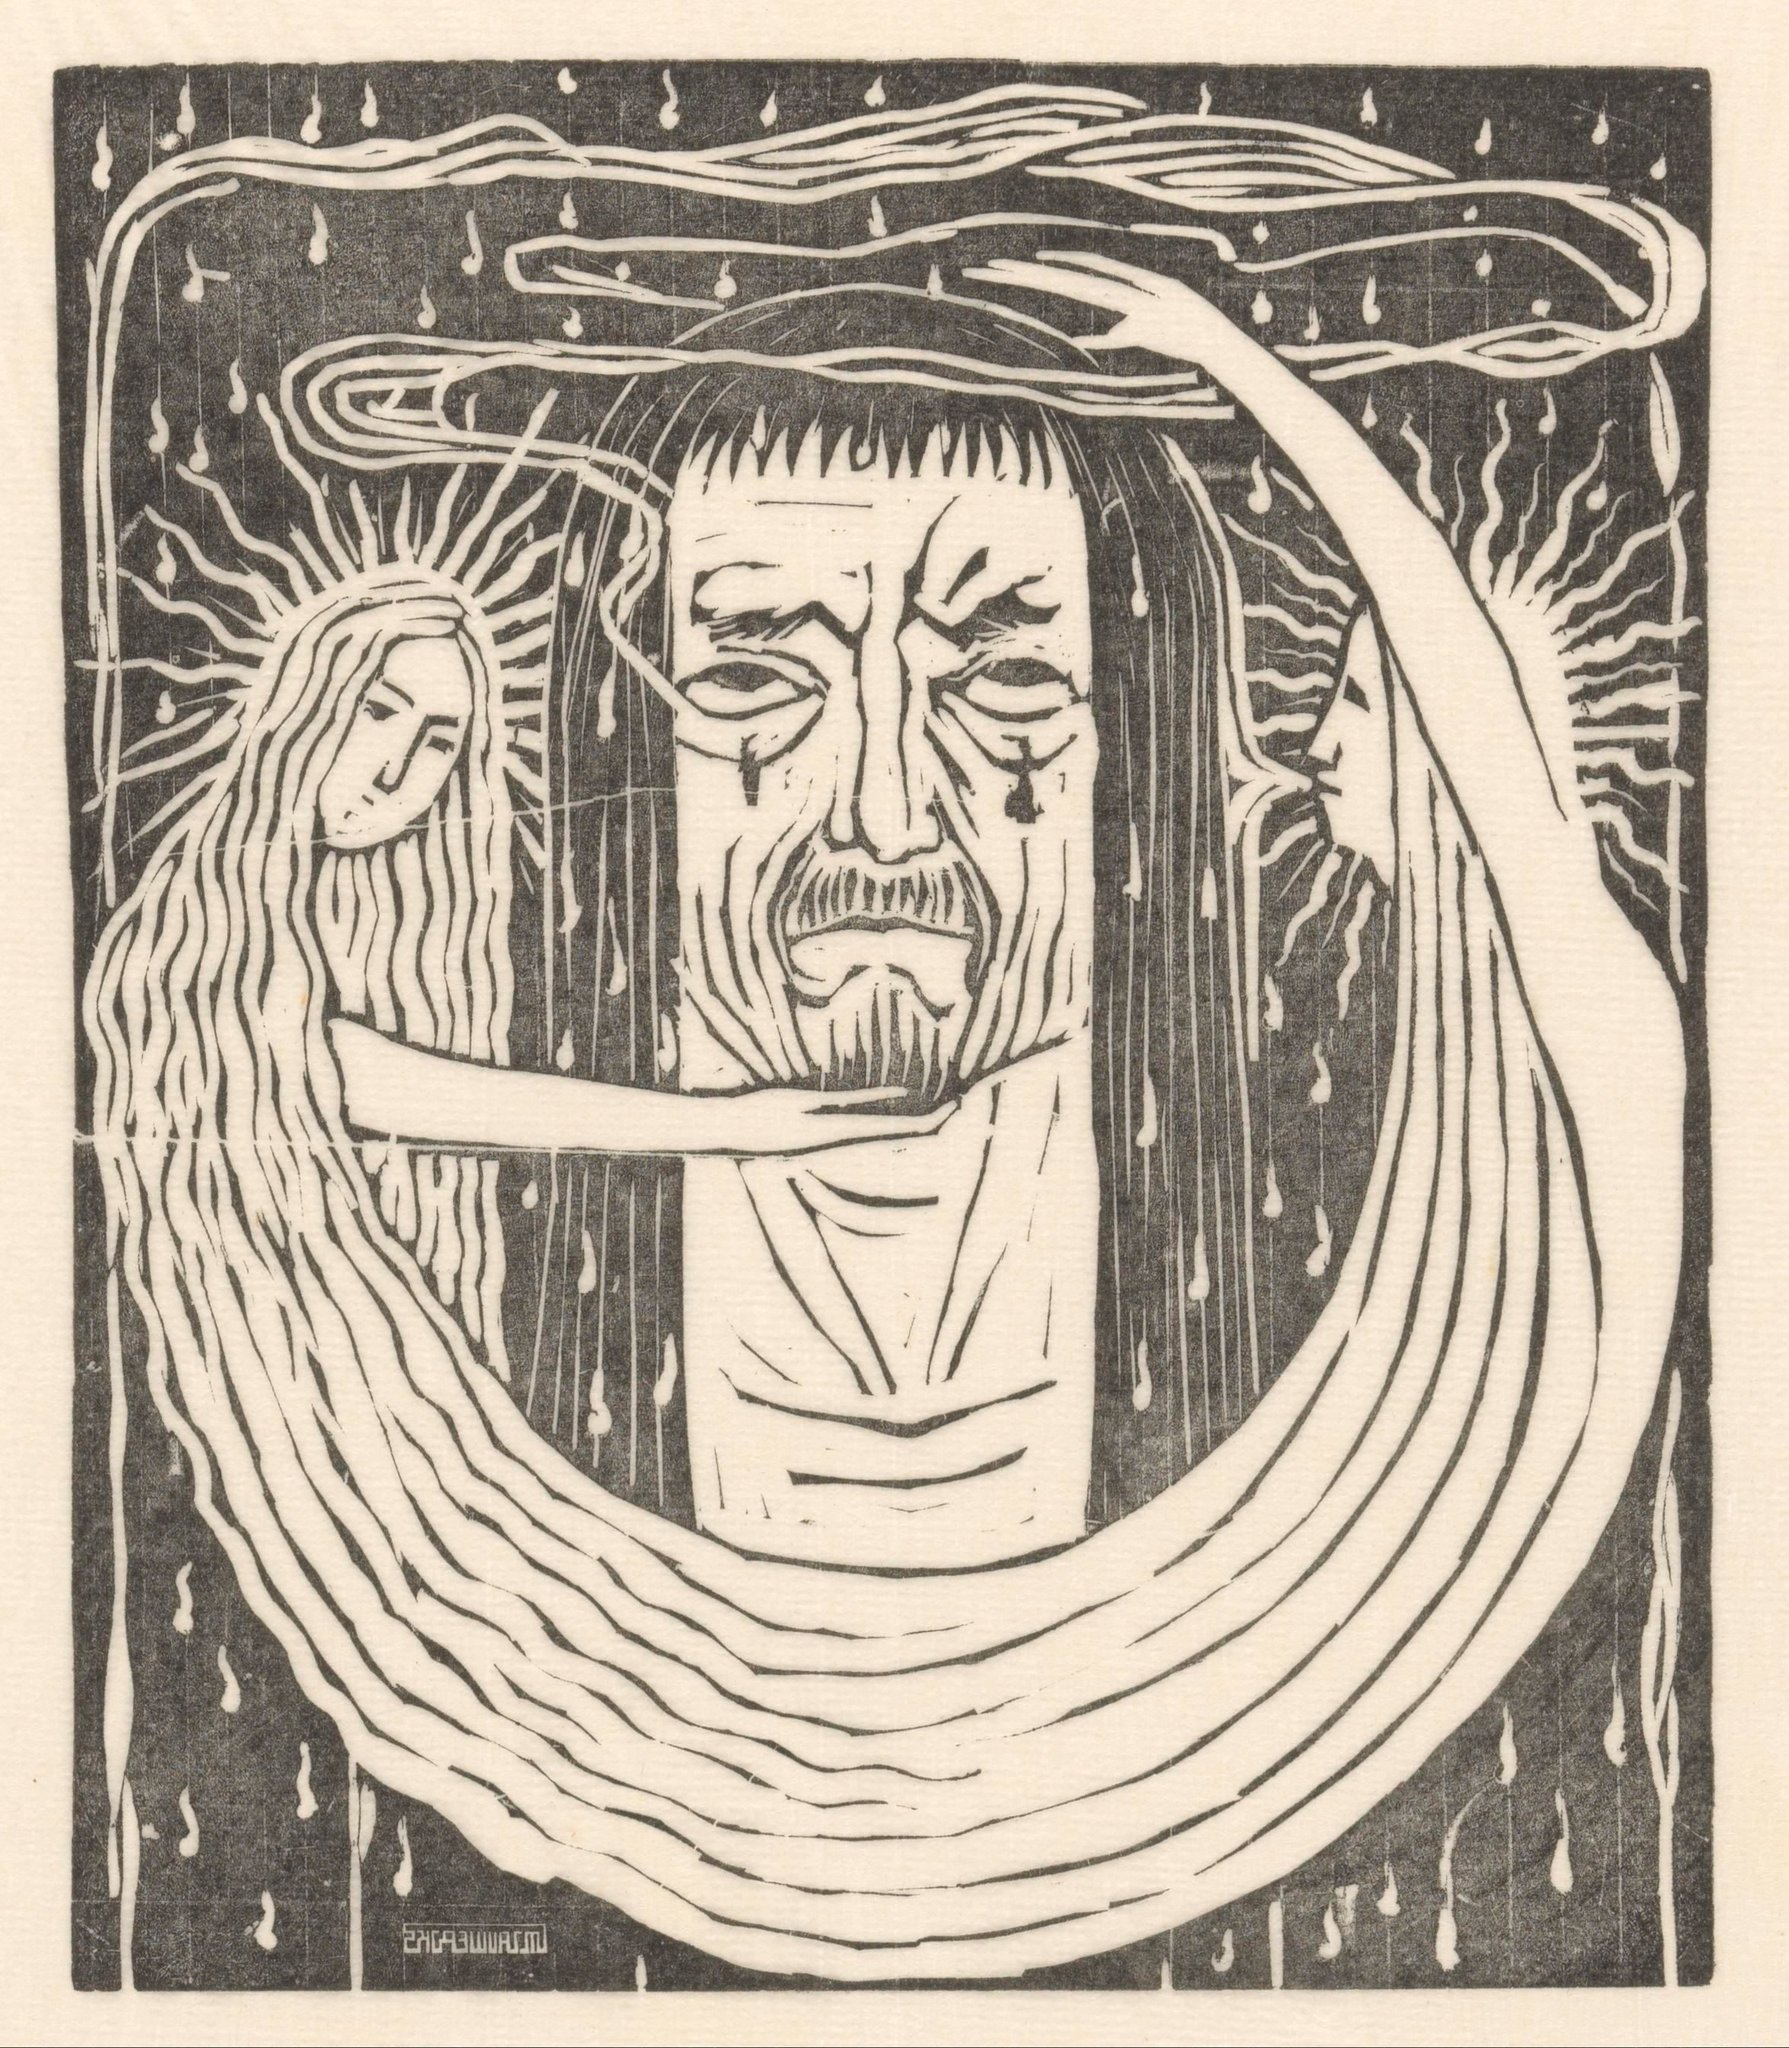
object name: illustration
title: Mannenhoofd en figuren in de regen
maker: mathieu lauweriks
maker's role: designer, draughtsman, print maker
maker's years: 1864-1932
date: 1894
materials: paper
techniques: woodcut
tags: head (human), twins, rain, mist, fog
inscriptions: collector's mark: Lugt 2228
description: In het midden het hoofd van een man in de regen. Boven hem mistslierten. Aan weerszijden wordt zijn hoofd aangeraakt door een vrouwelijk figuur met stralen rond het hoofd. De twee vrouwelijke figuren zijn aan elkaar verbonden met een boog van haar.